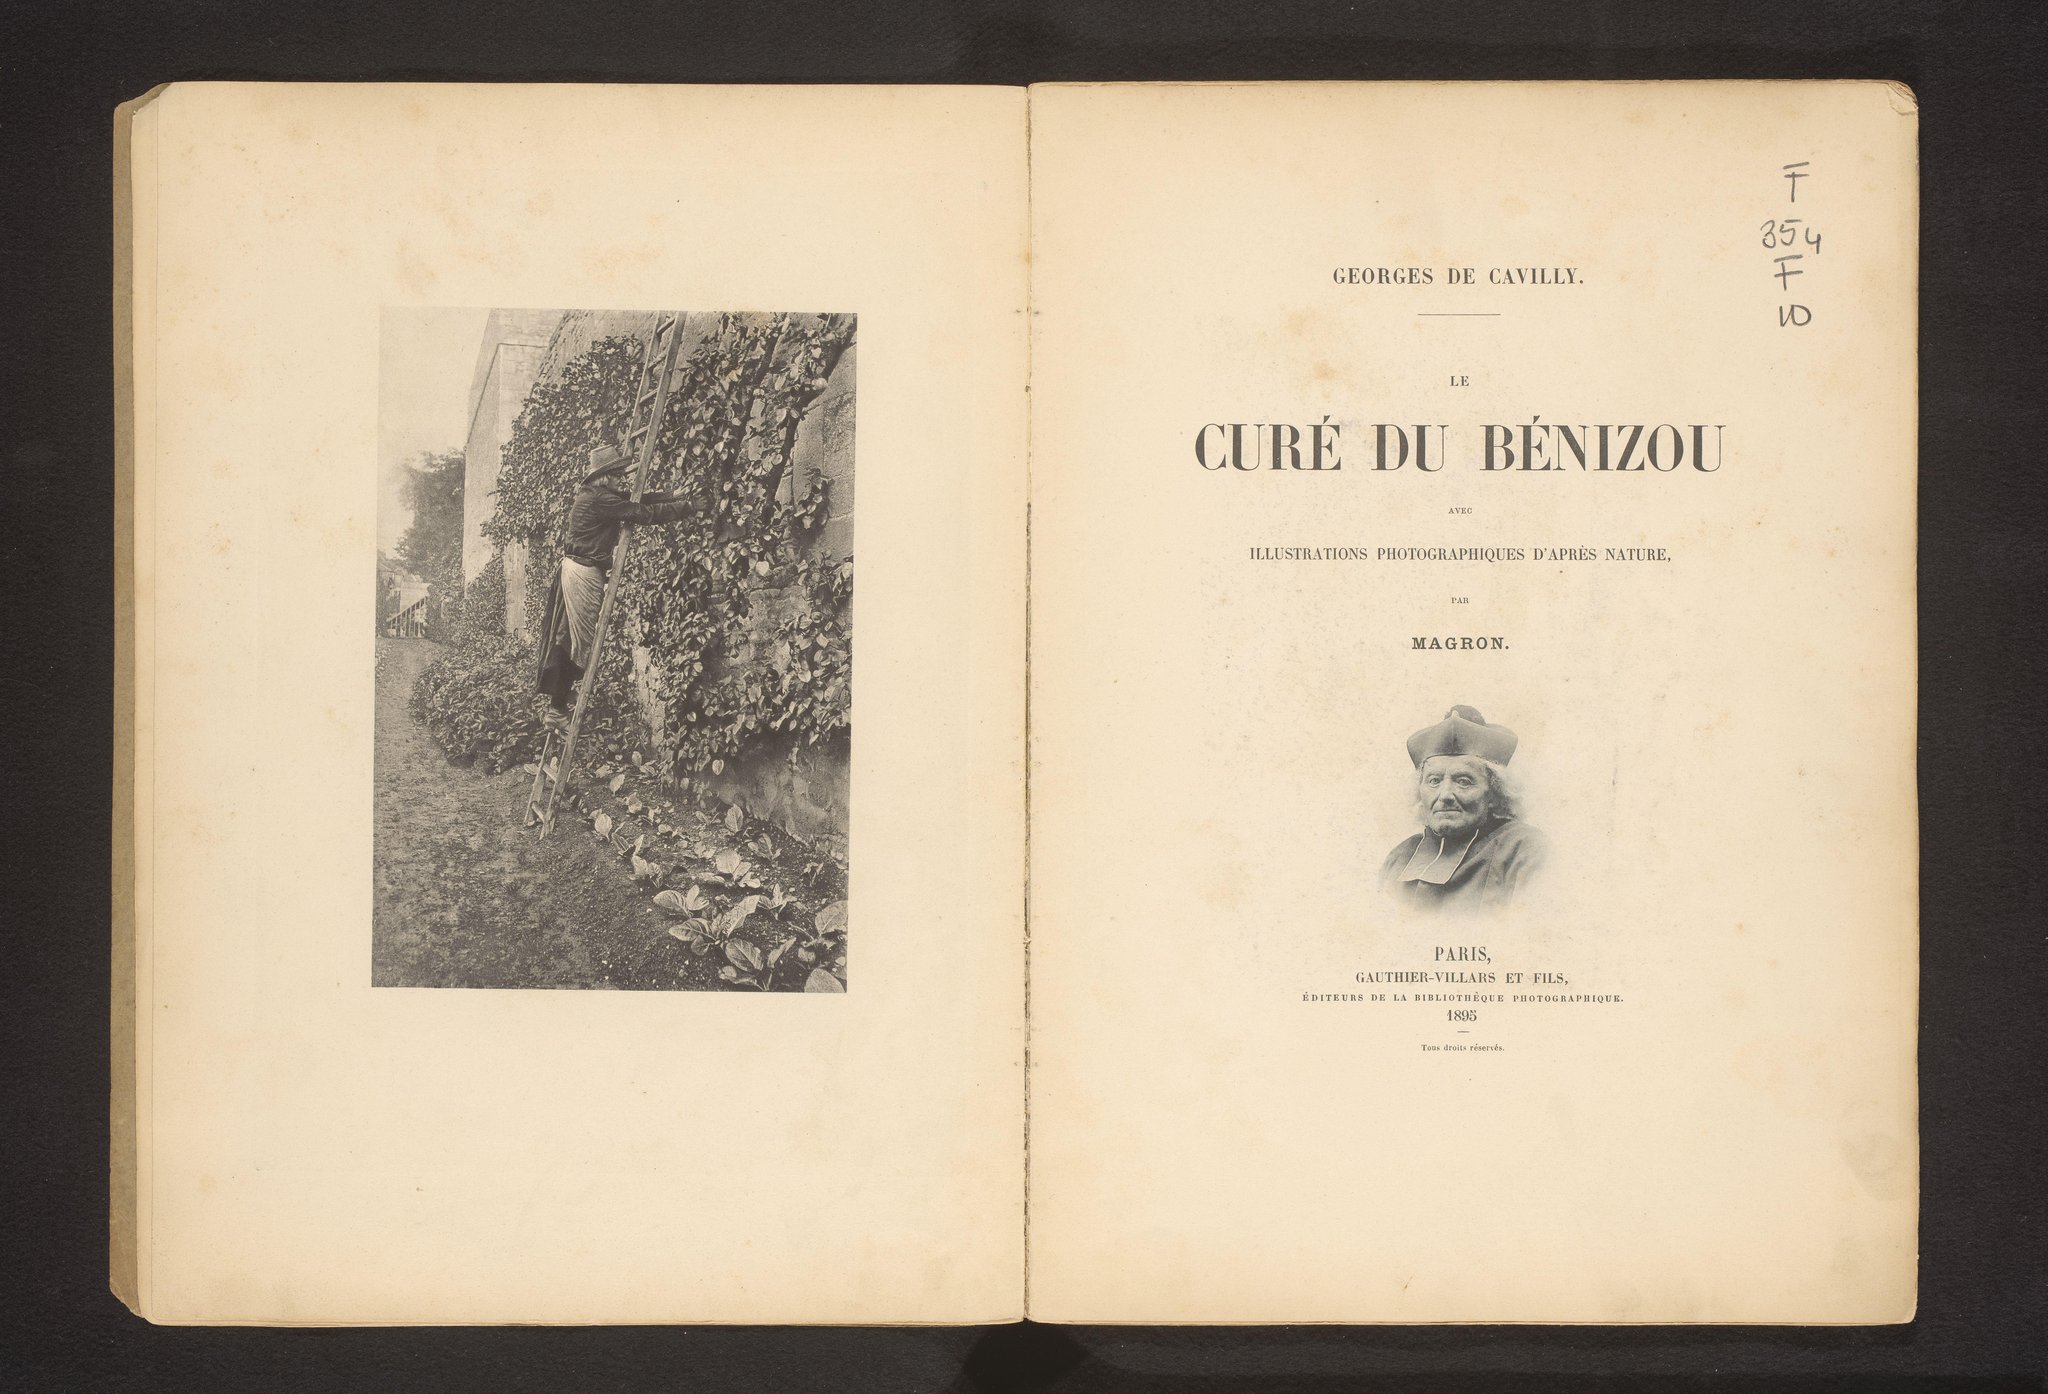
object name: book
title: Curé de Bénizou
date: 1895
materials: paper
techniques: photograph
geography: paris